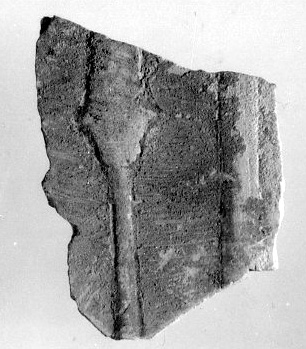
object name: relief fragment, tomb of meketre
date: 1981-1975 BCE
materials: limestone, paint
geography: egypt